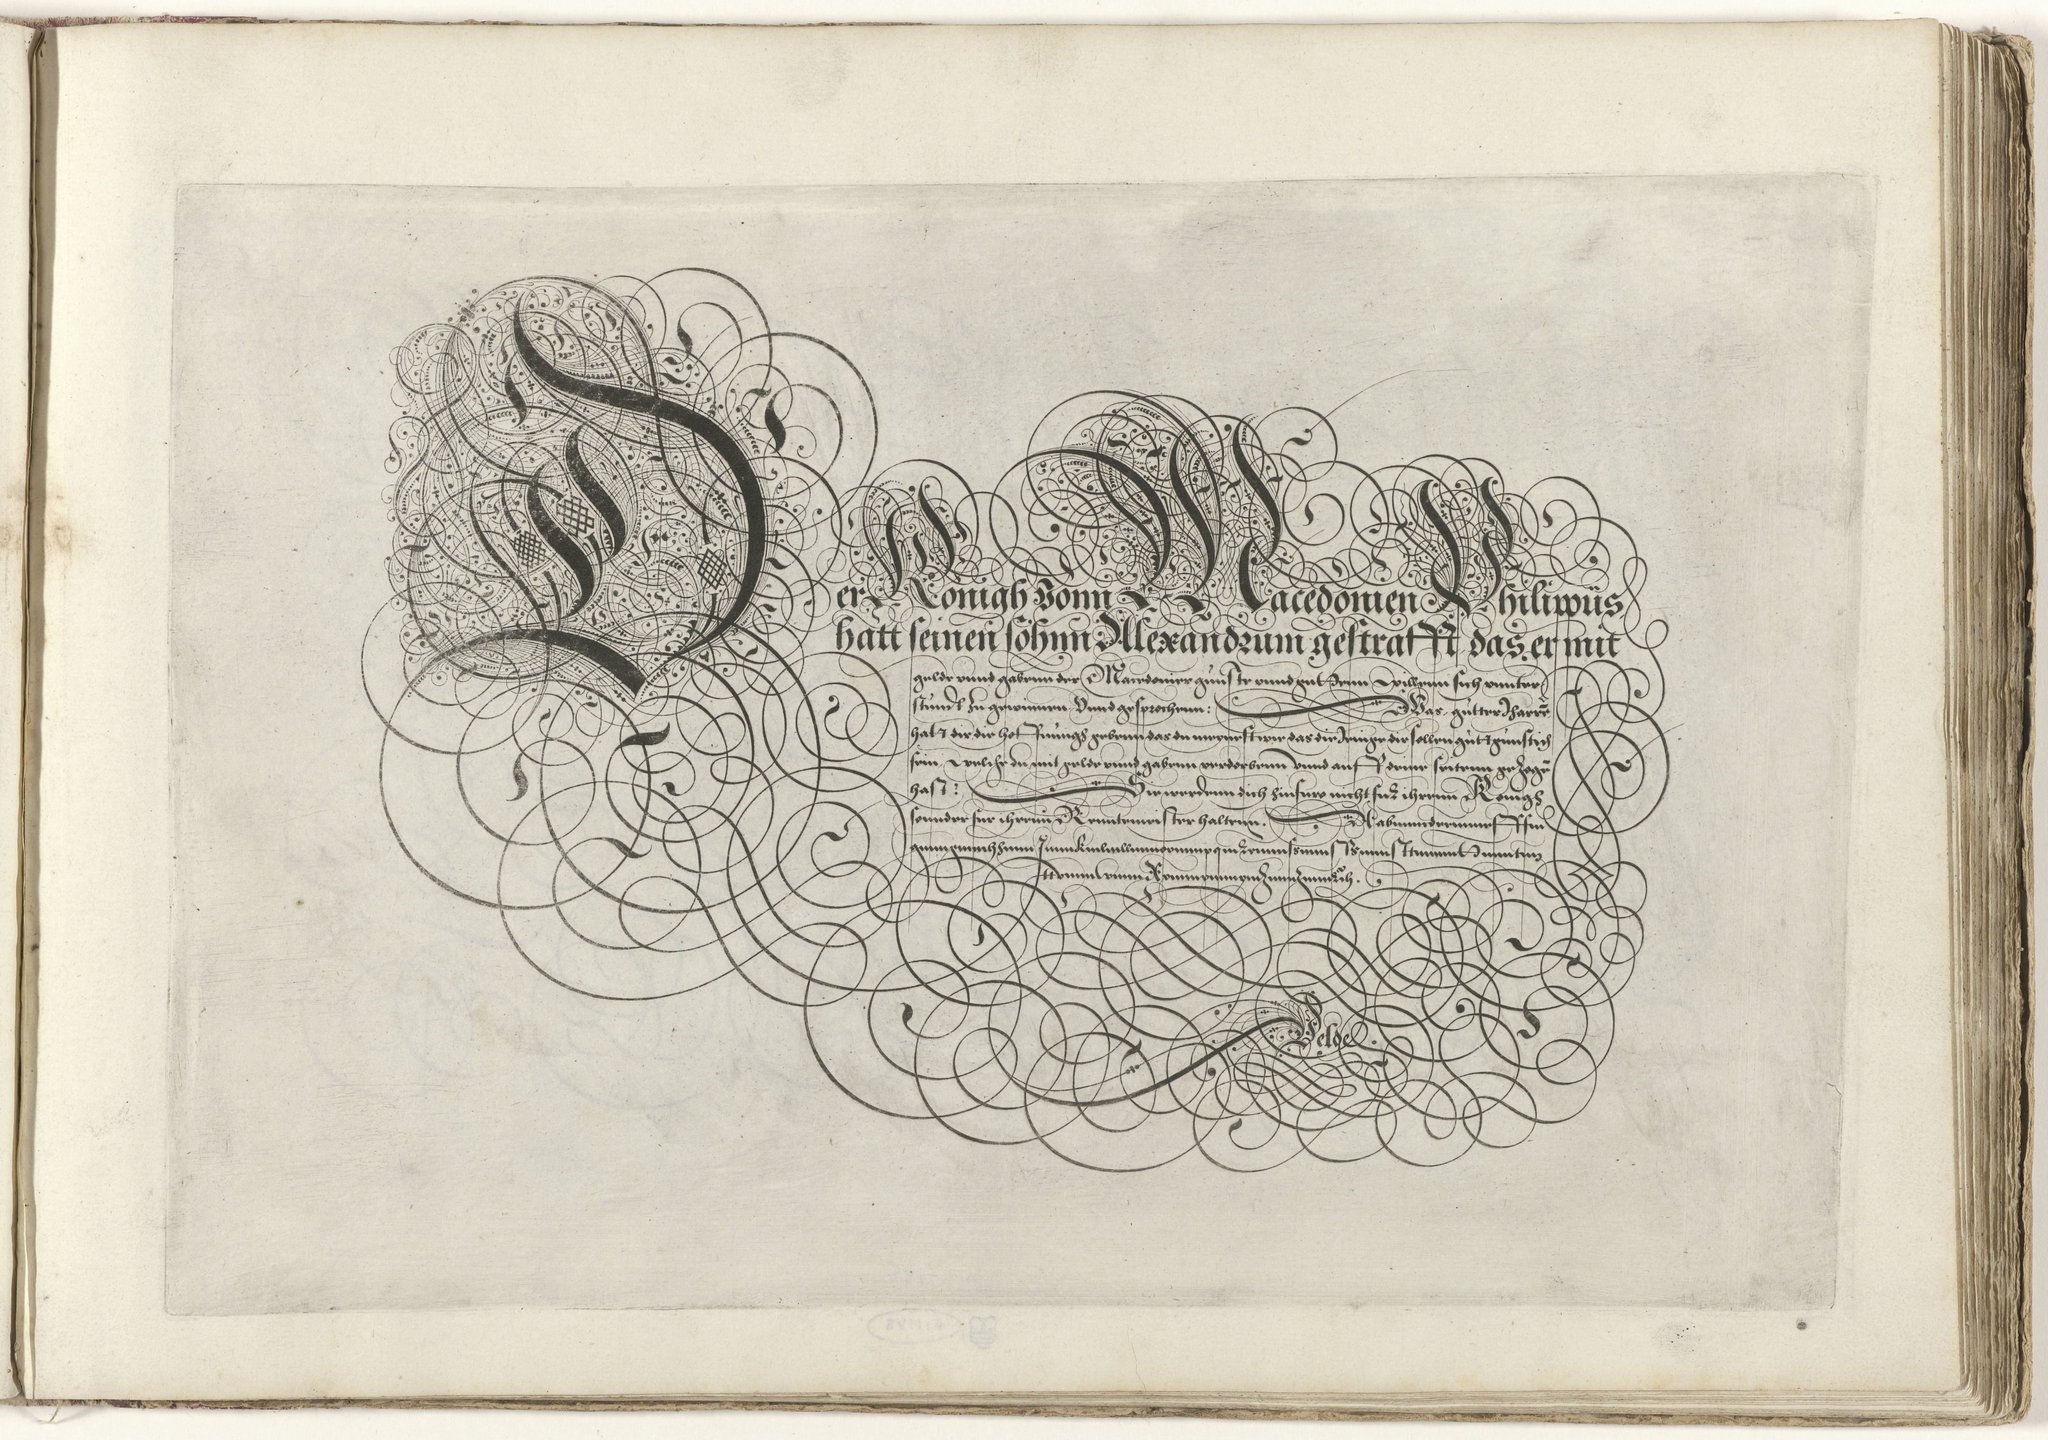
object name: print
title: Schrijfvoorbeeld: Der konigh vonn Macedonien (...)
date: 1605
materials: paper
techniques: engraving, intaglio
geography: amsterdam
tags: calligraphy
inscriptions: collector's mark: Lugt 2760, collector's mark: Lugt 2228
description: Schrijfvoorbeeld met geornamenteerde initialen D, K, M en P en tien regels tekst in het Duits: Der konigh vonn Macedonien ... De tekst is omlijst door krulwerk. De prent maakt deel uit van een album.